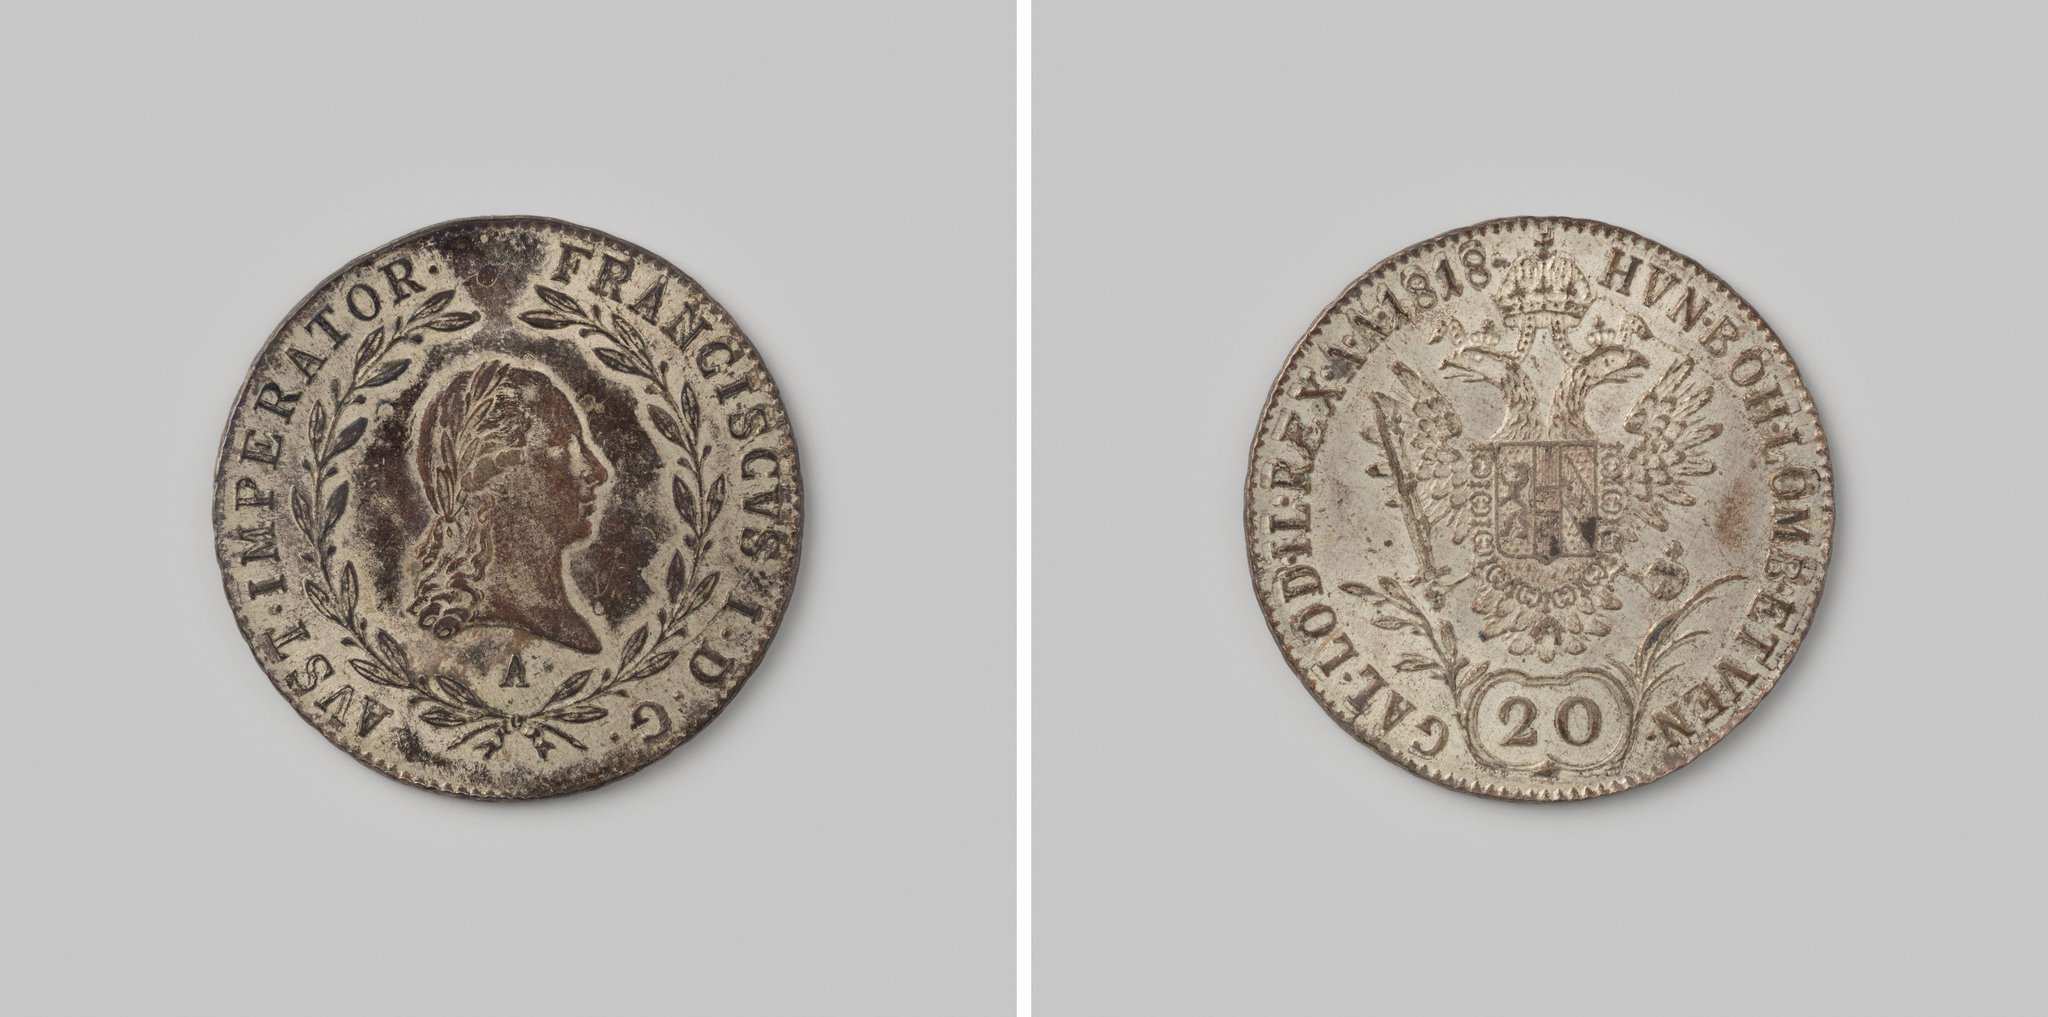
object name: twintig kreuzer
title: Twintig kreuzer uit het keizerrijk Oostenrijk van Franz I, 1818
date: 1818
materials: silver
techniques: striking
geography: vienna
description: Zilveren munt. Voorzijde: binnen twee samengebonden takken gelauwerd hoofd van de keizer naar rechts, waaronder letter A [=Wenen]. Keerzijde: gekroonde dubbelkoppige adelaar met op de koppen kleine kronen. Op zijn borst door ridderorde omhangen samengesteld wapenschild en in zijn poten een zwaard en een rijksappel. Daaronder binnen versiering waarde-aanduiding. Jaartal aan het eind van het omschrift. Kabelrand.